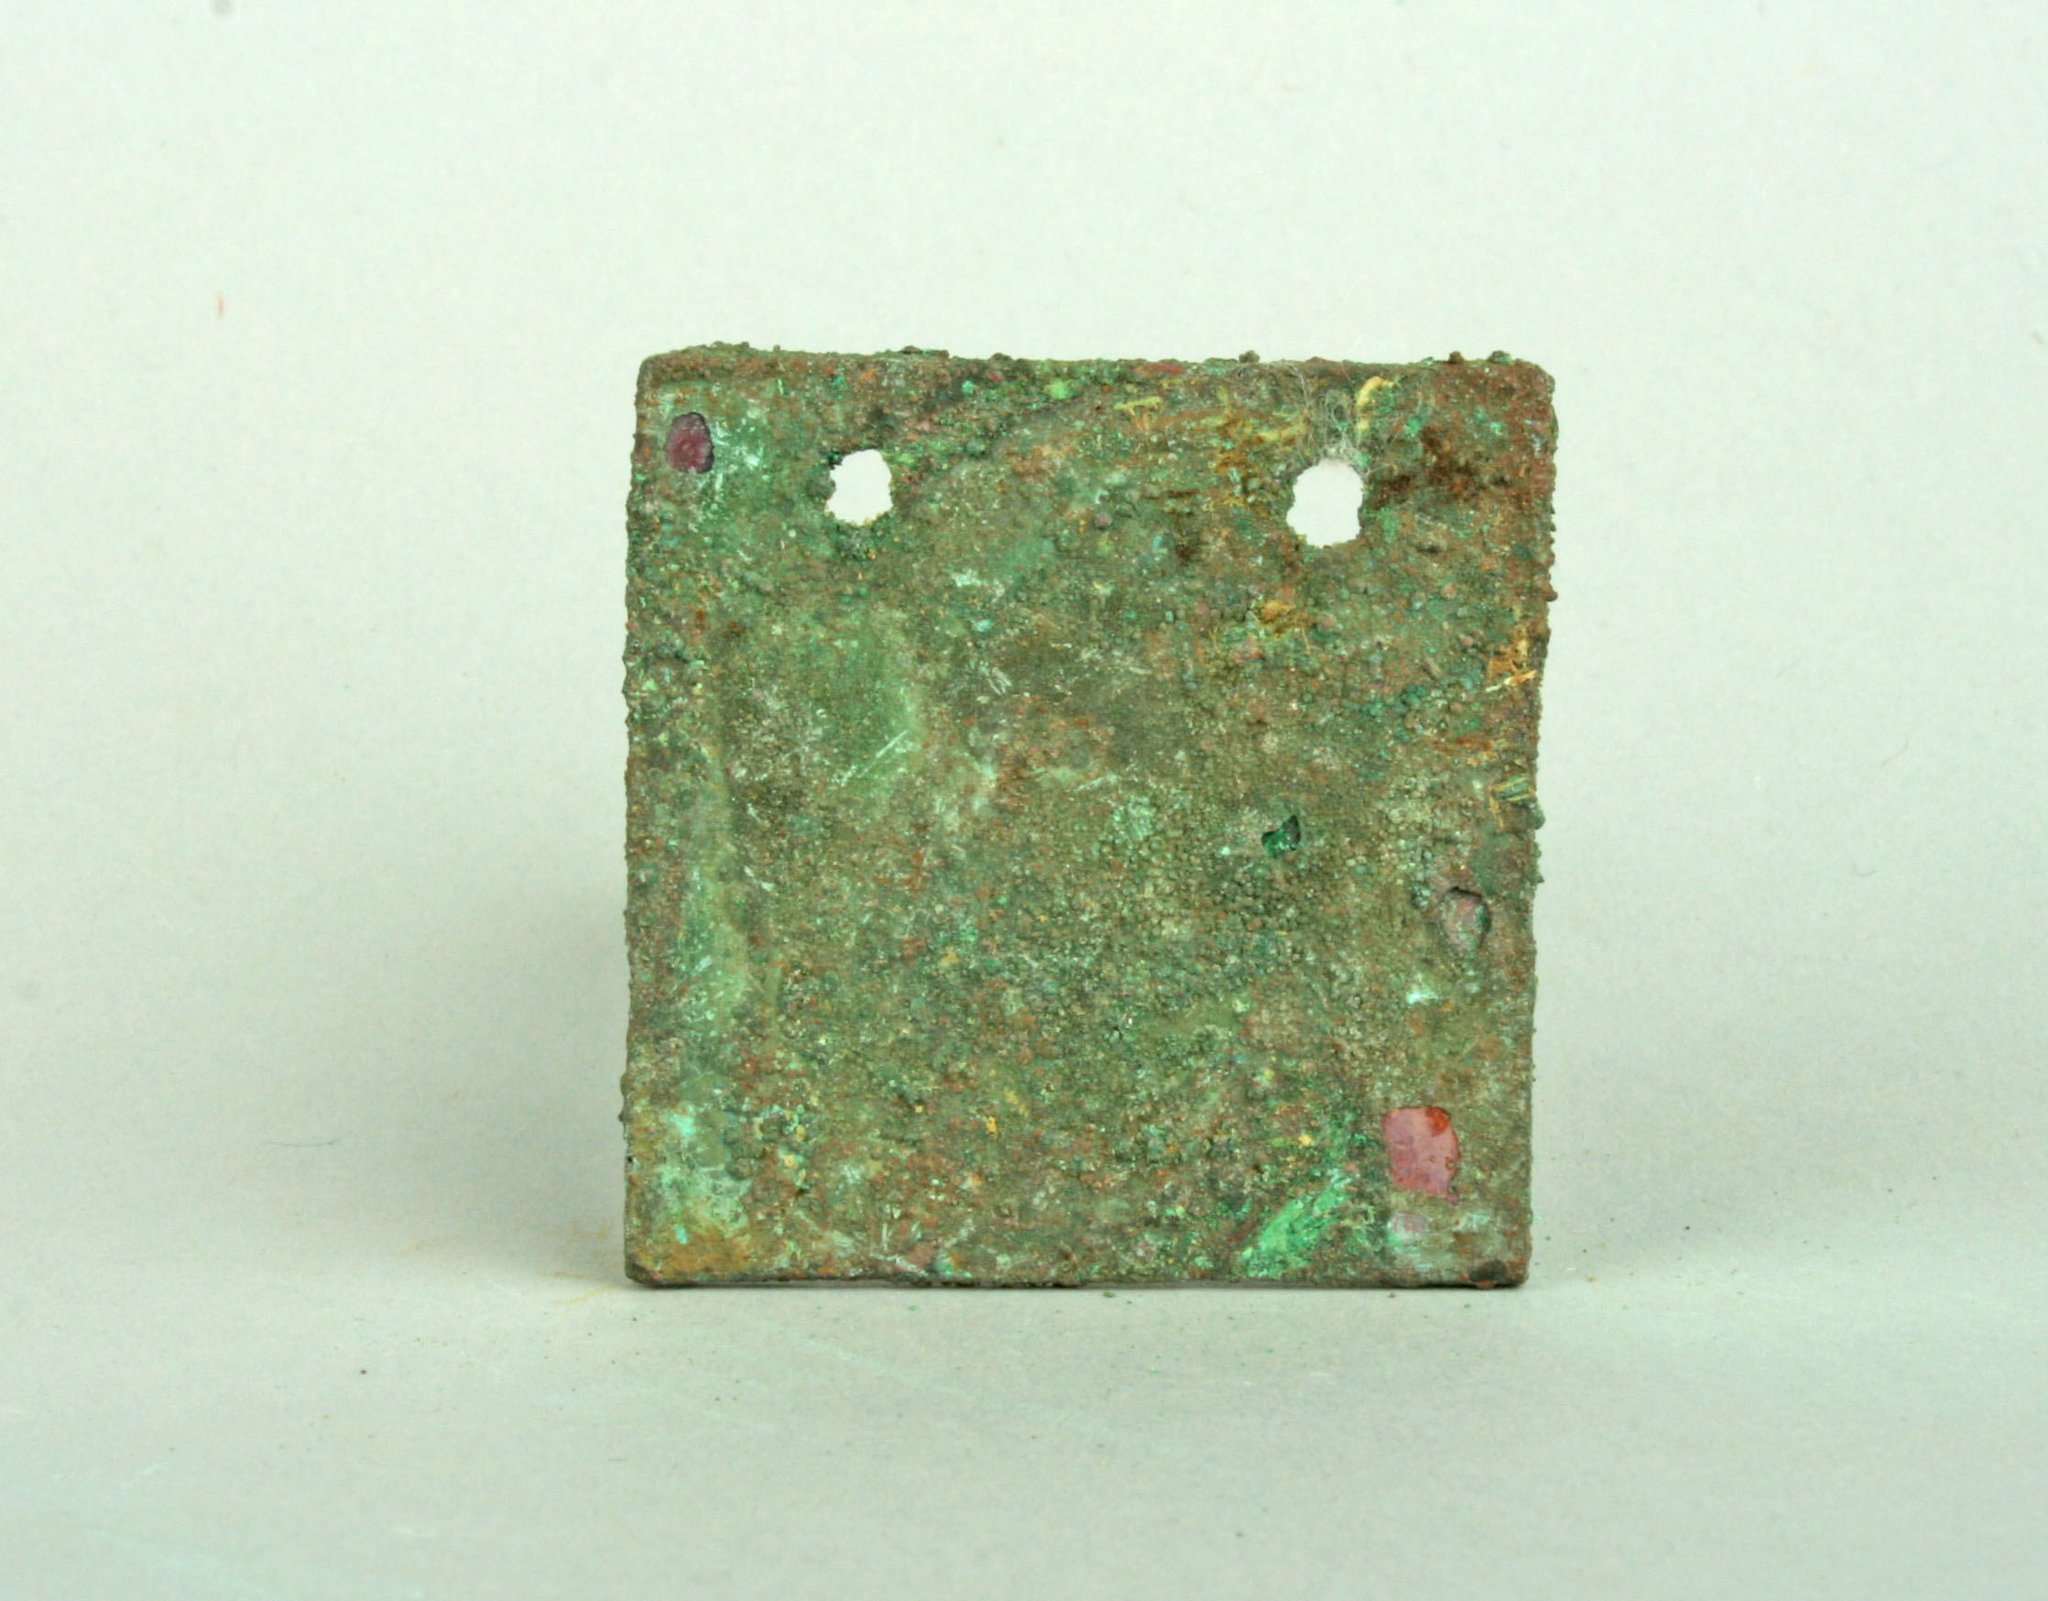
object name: plaque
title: Square Plaque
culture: vicús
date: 300 BCE-200 CE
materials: copper, gilt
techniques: hammering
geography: peru